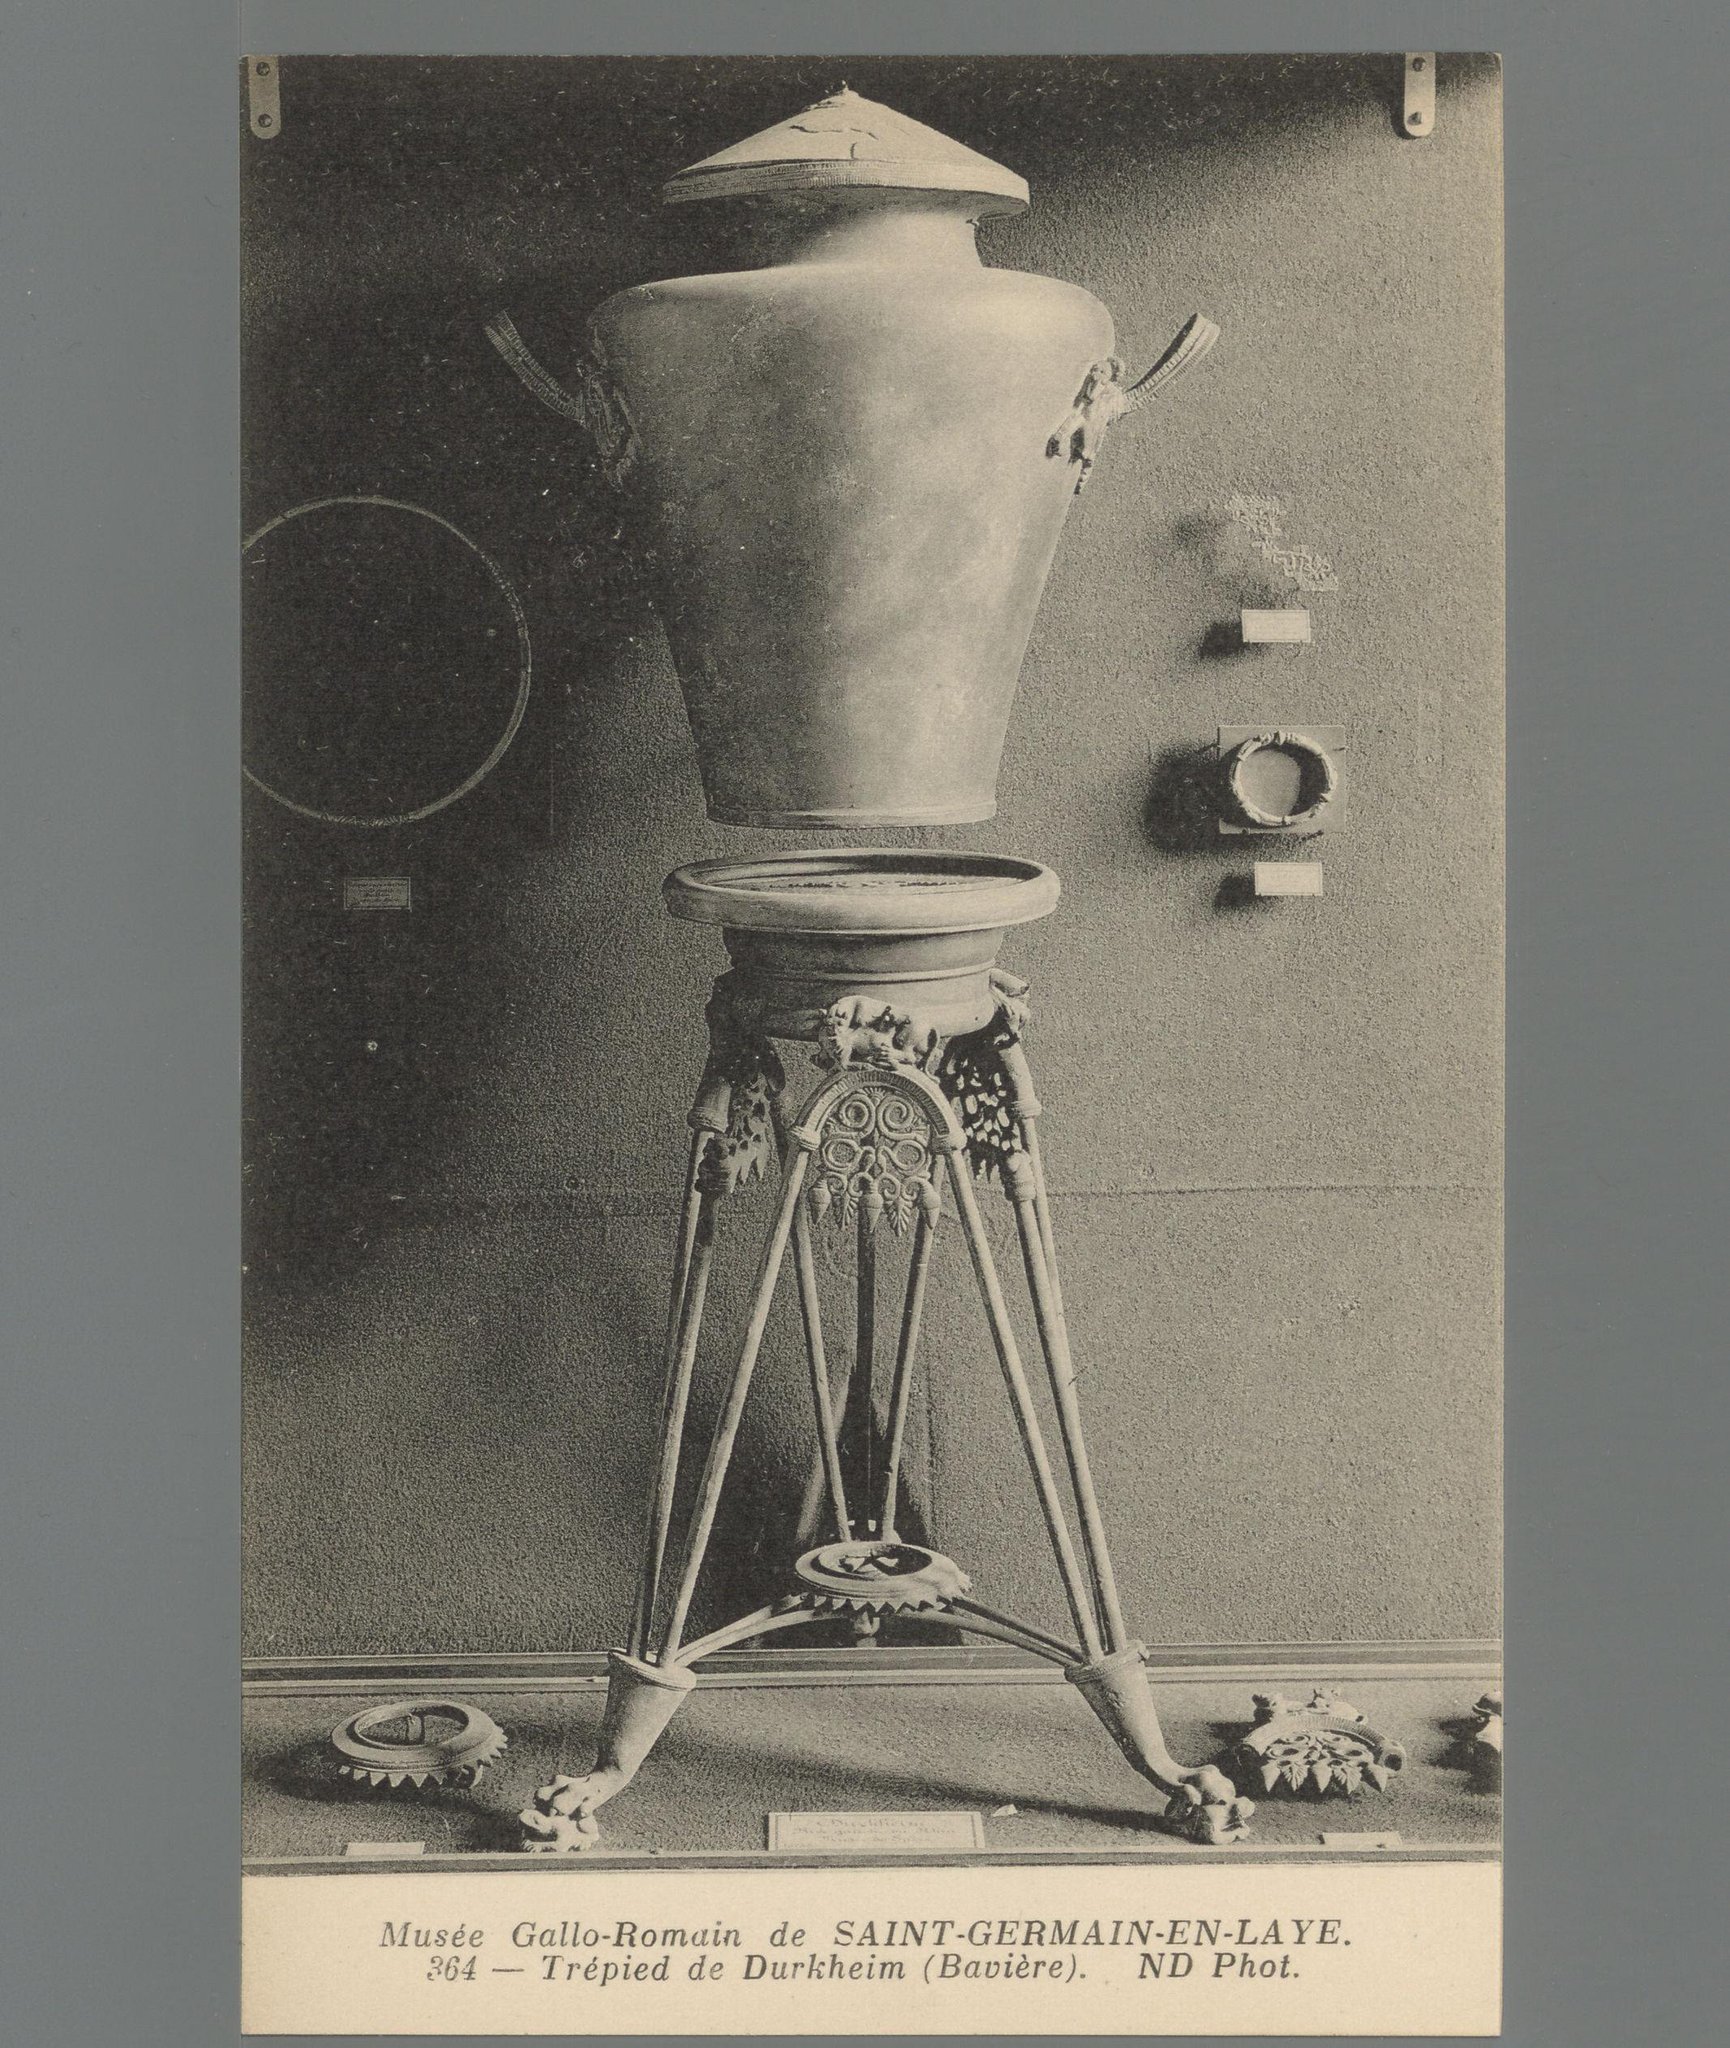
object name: ansichtkaart, prentbriefkaart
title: Trépied de Durkheim (Bavière)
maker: Anonymous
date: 1903-1918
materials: cardboard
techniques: photograph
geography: saint-germain-en-laye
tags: permanent exhibition, museum, container of precious metal